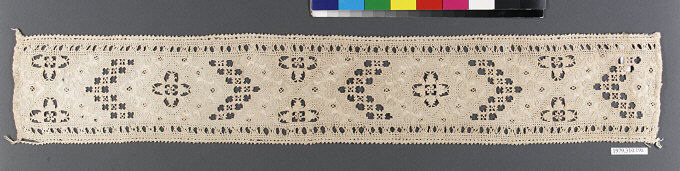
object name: band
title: Bands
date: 1401-1600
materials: linen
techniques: lace